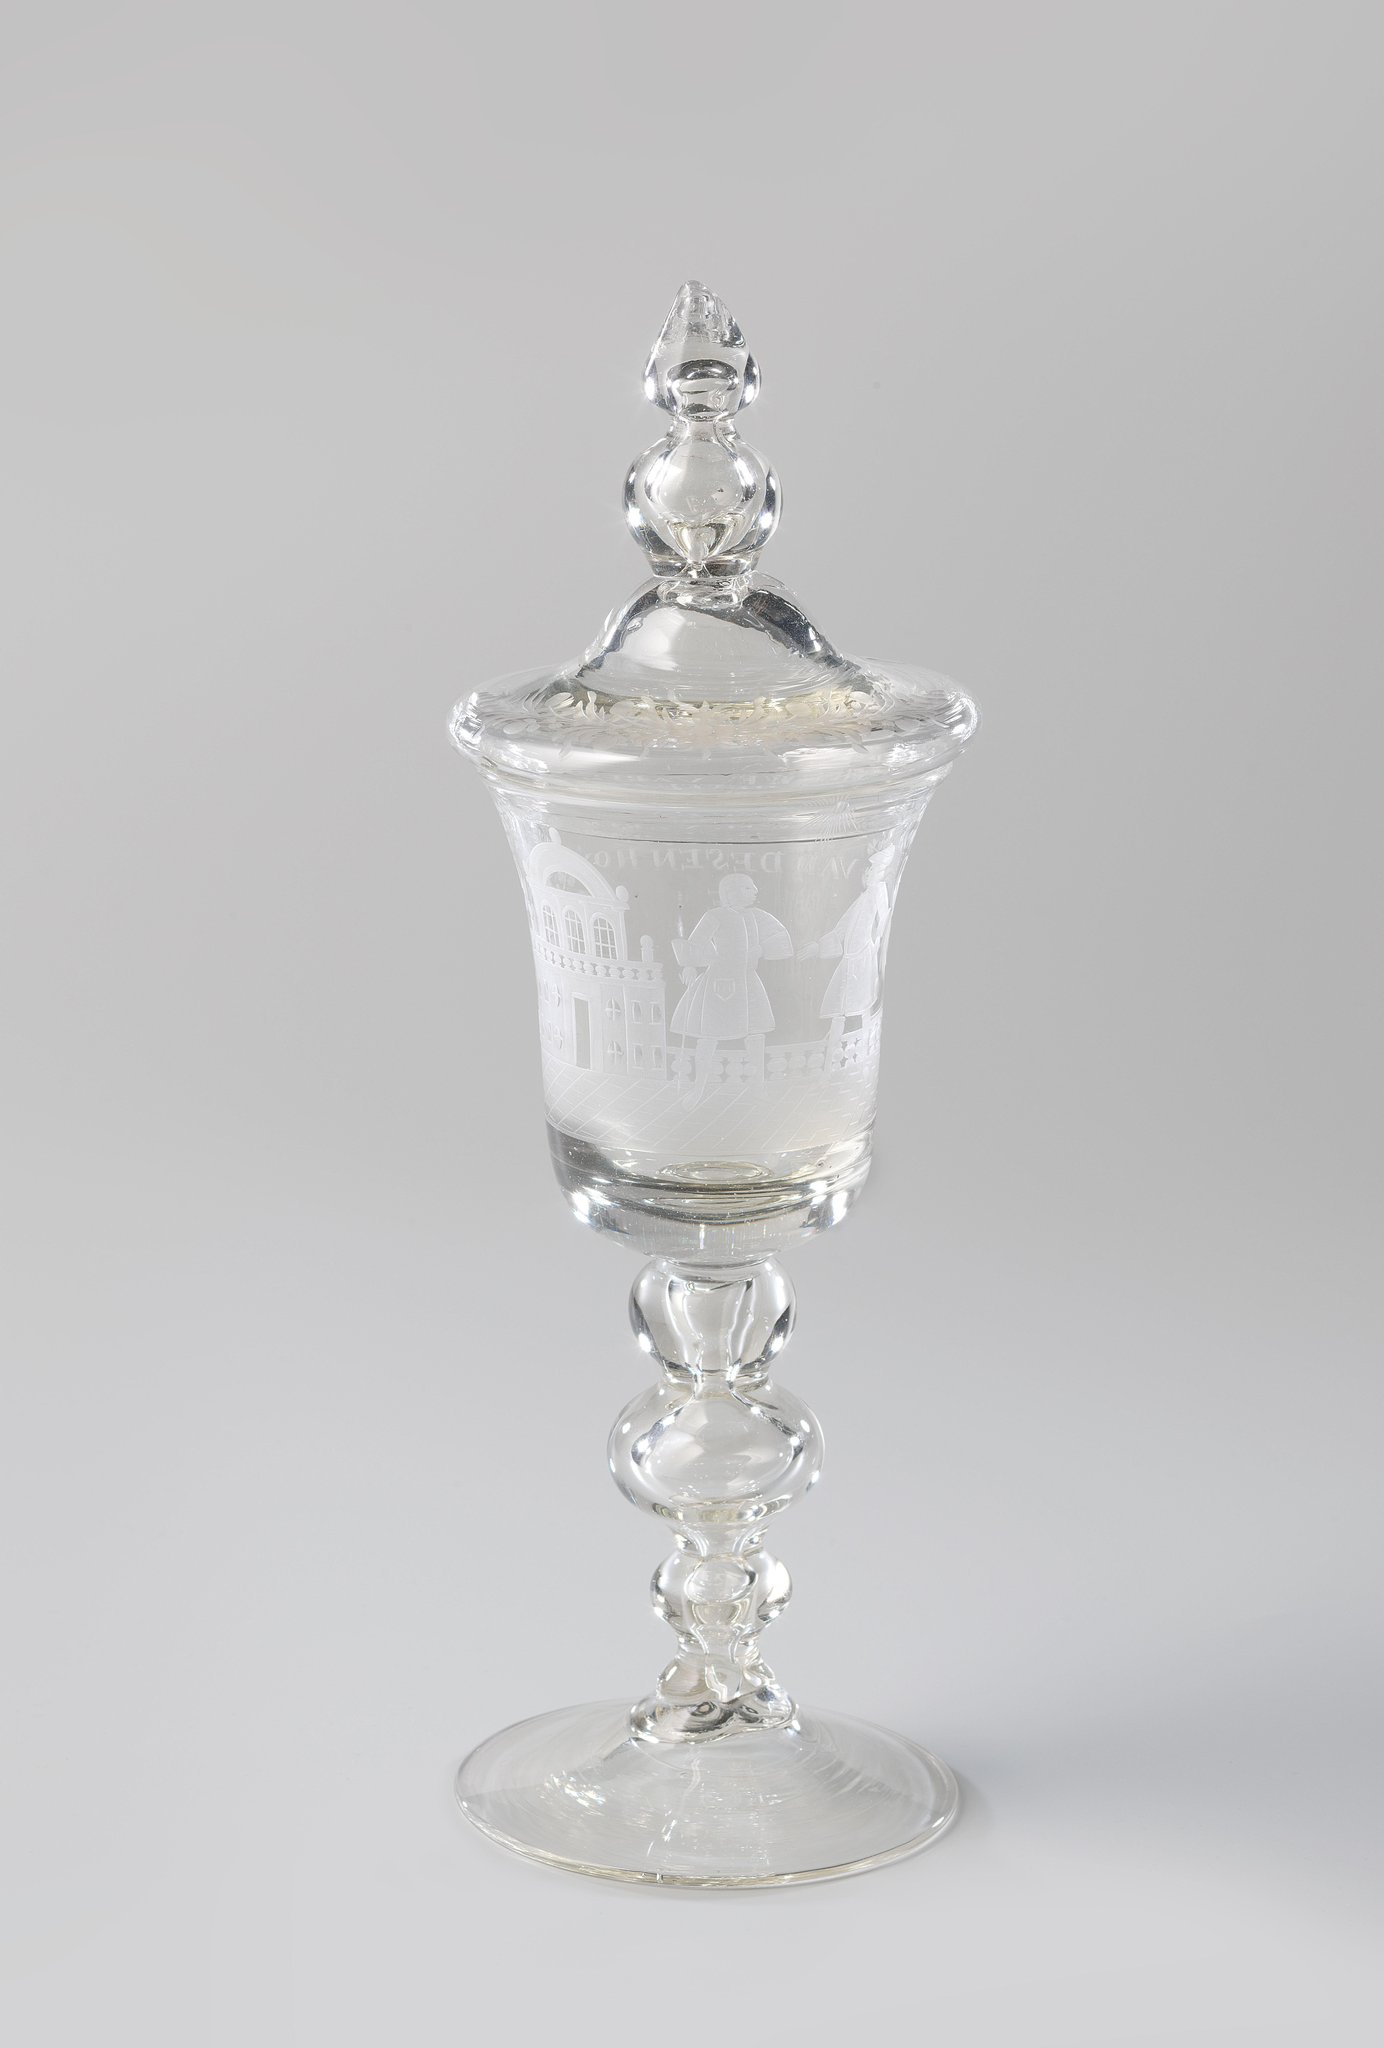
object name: goblet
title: Bokaal, met een huis en twee heren en het opschrift: HET WELVAREN VAN DESE HOYSE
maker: Anonymous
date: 1725-1750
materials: glass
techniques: glassblowing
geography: germany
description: Conische voet met omgeslagen rand. Stam met drie holle knopen, overigens van dik glas. Op de kelk een huis en twee heren in 18de-eeuwse klederdracht tussen bloemkransen. Daarachter: HET WEL VAREN/ VAN DESE HOY/ SE. Op het deksel een bloementuil.